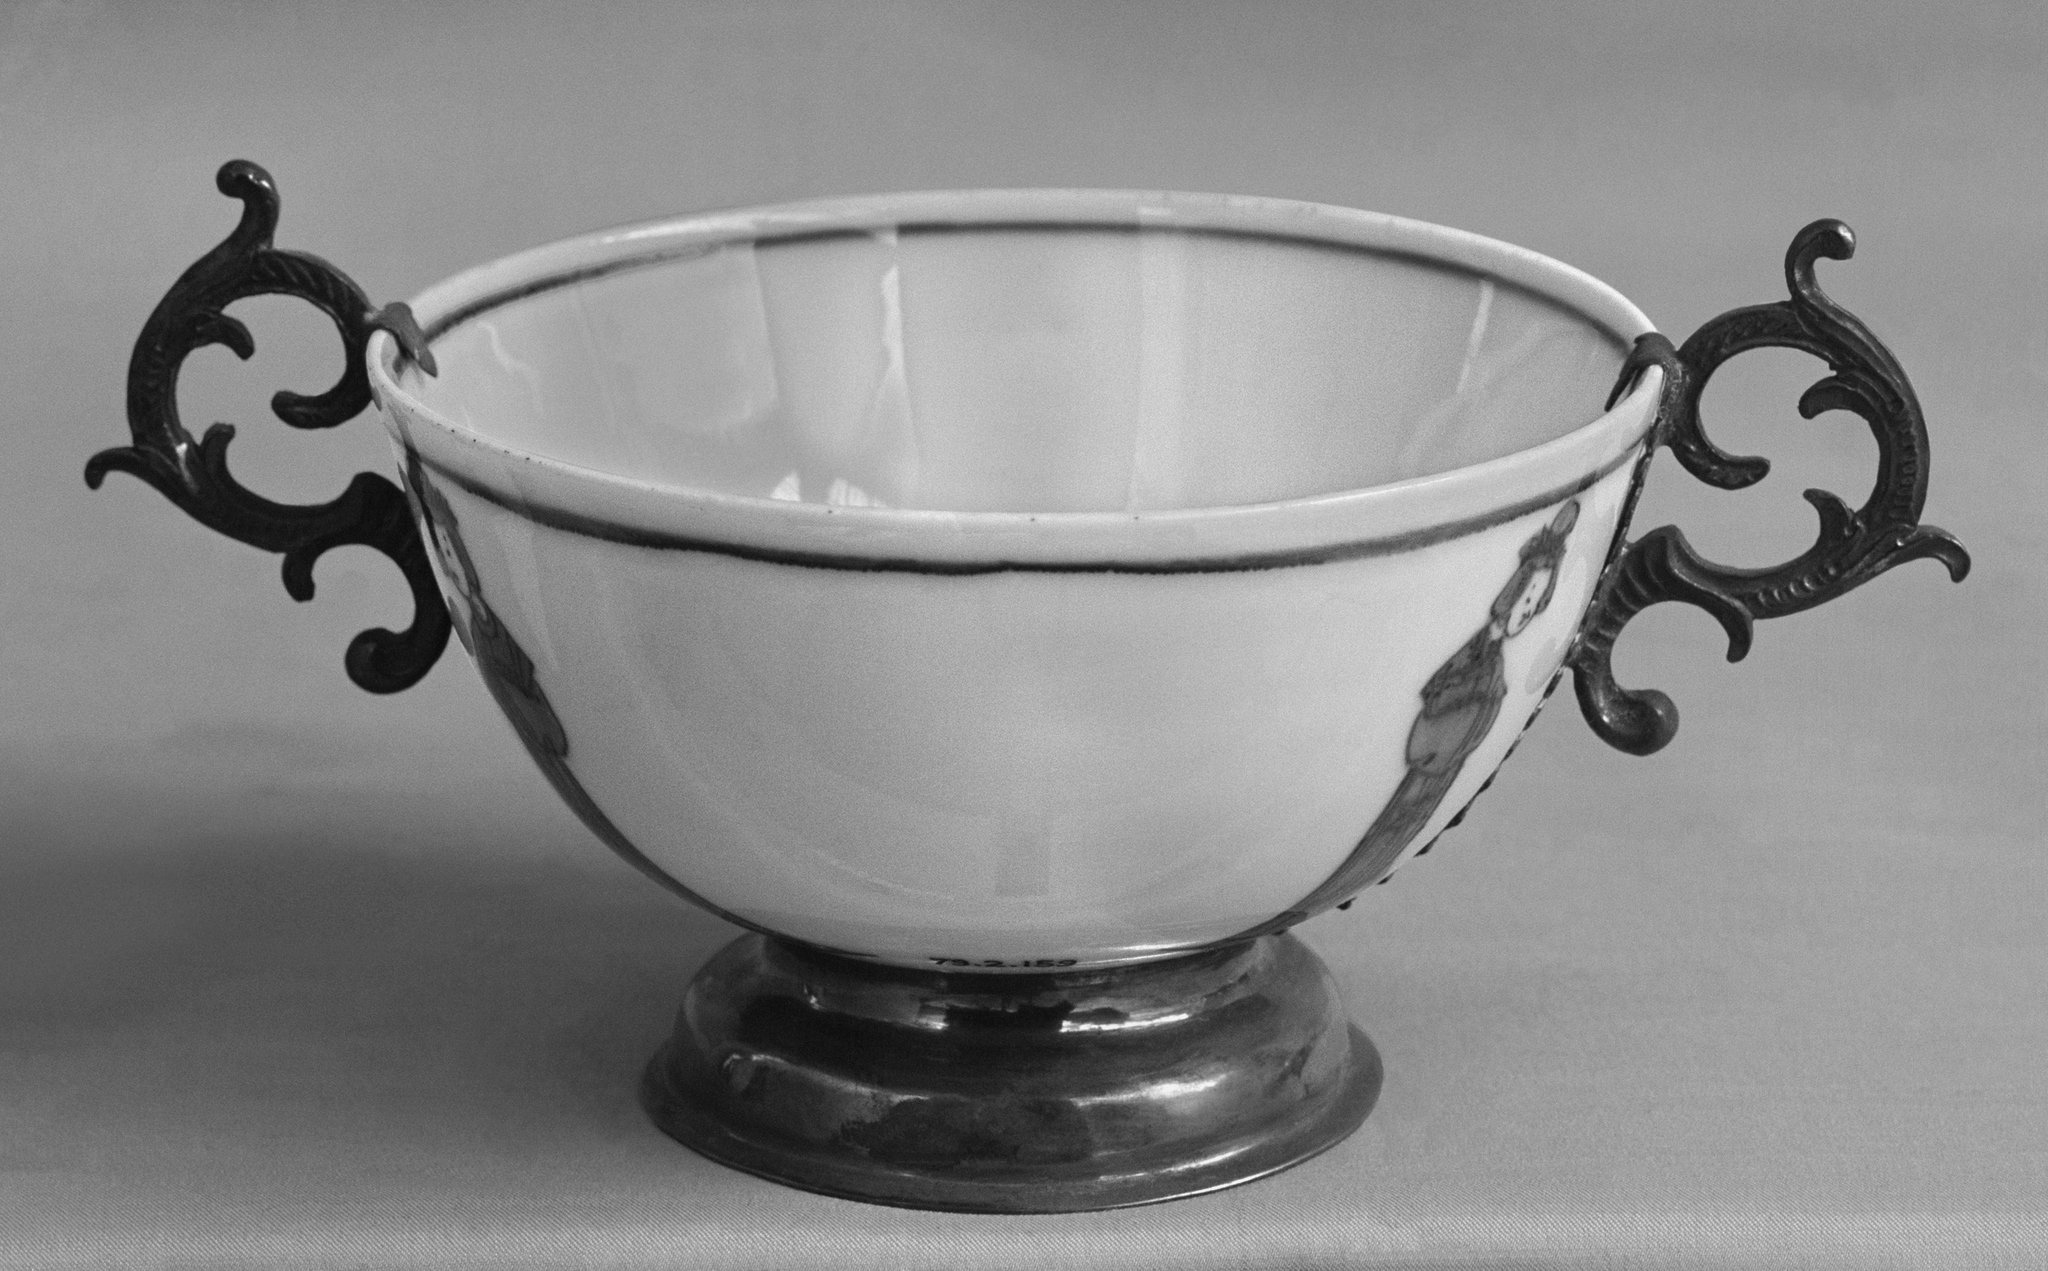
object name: cup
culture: chinese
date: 1501-1600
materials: porcelain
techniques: painting, underglaze